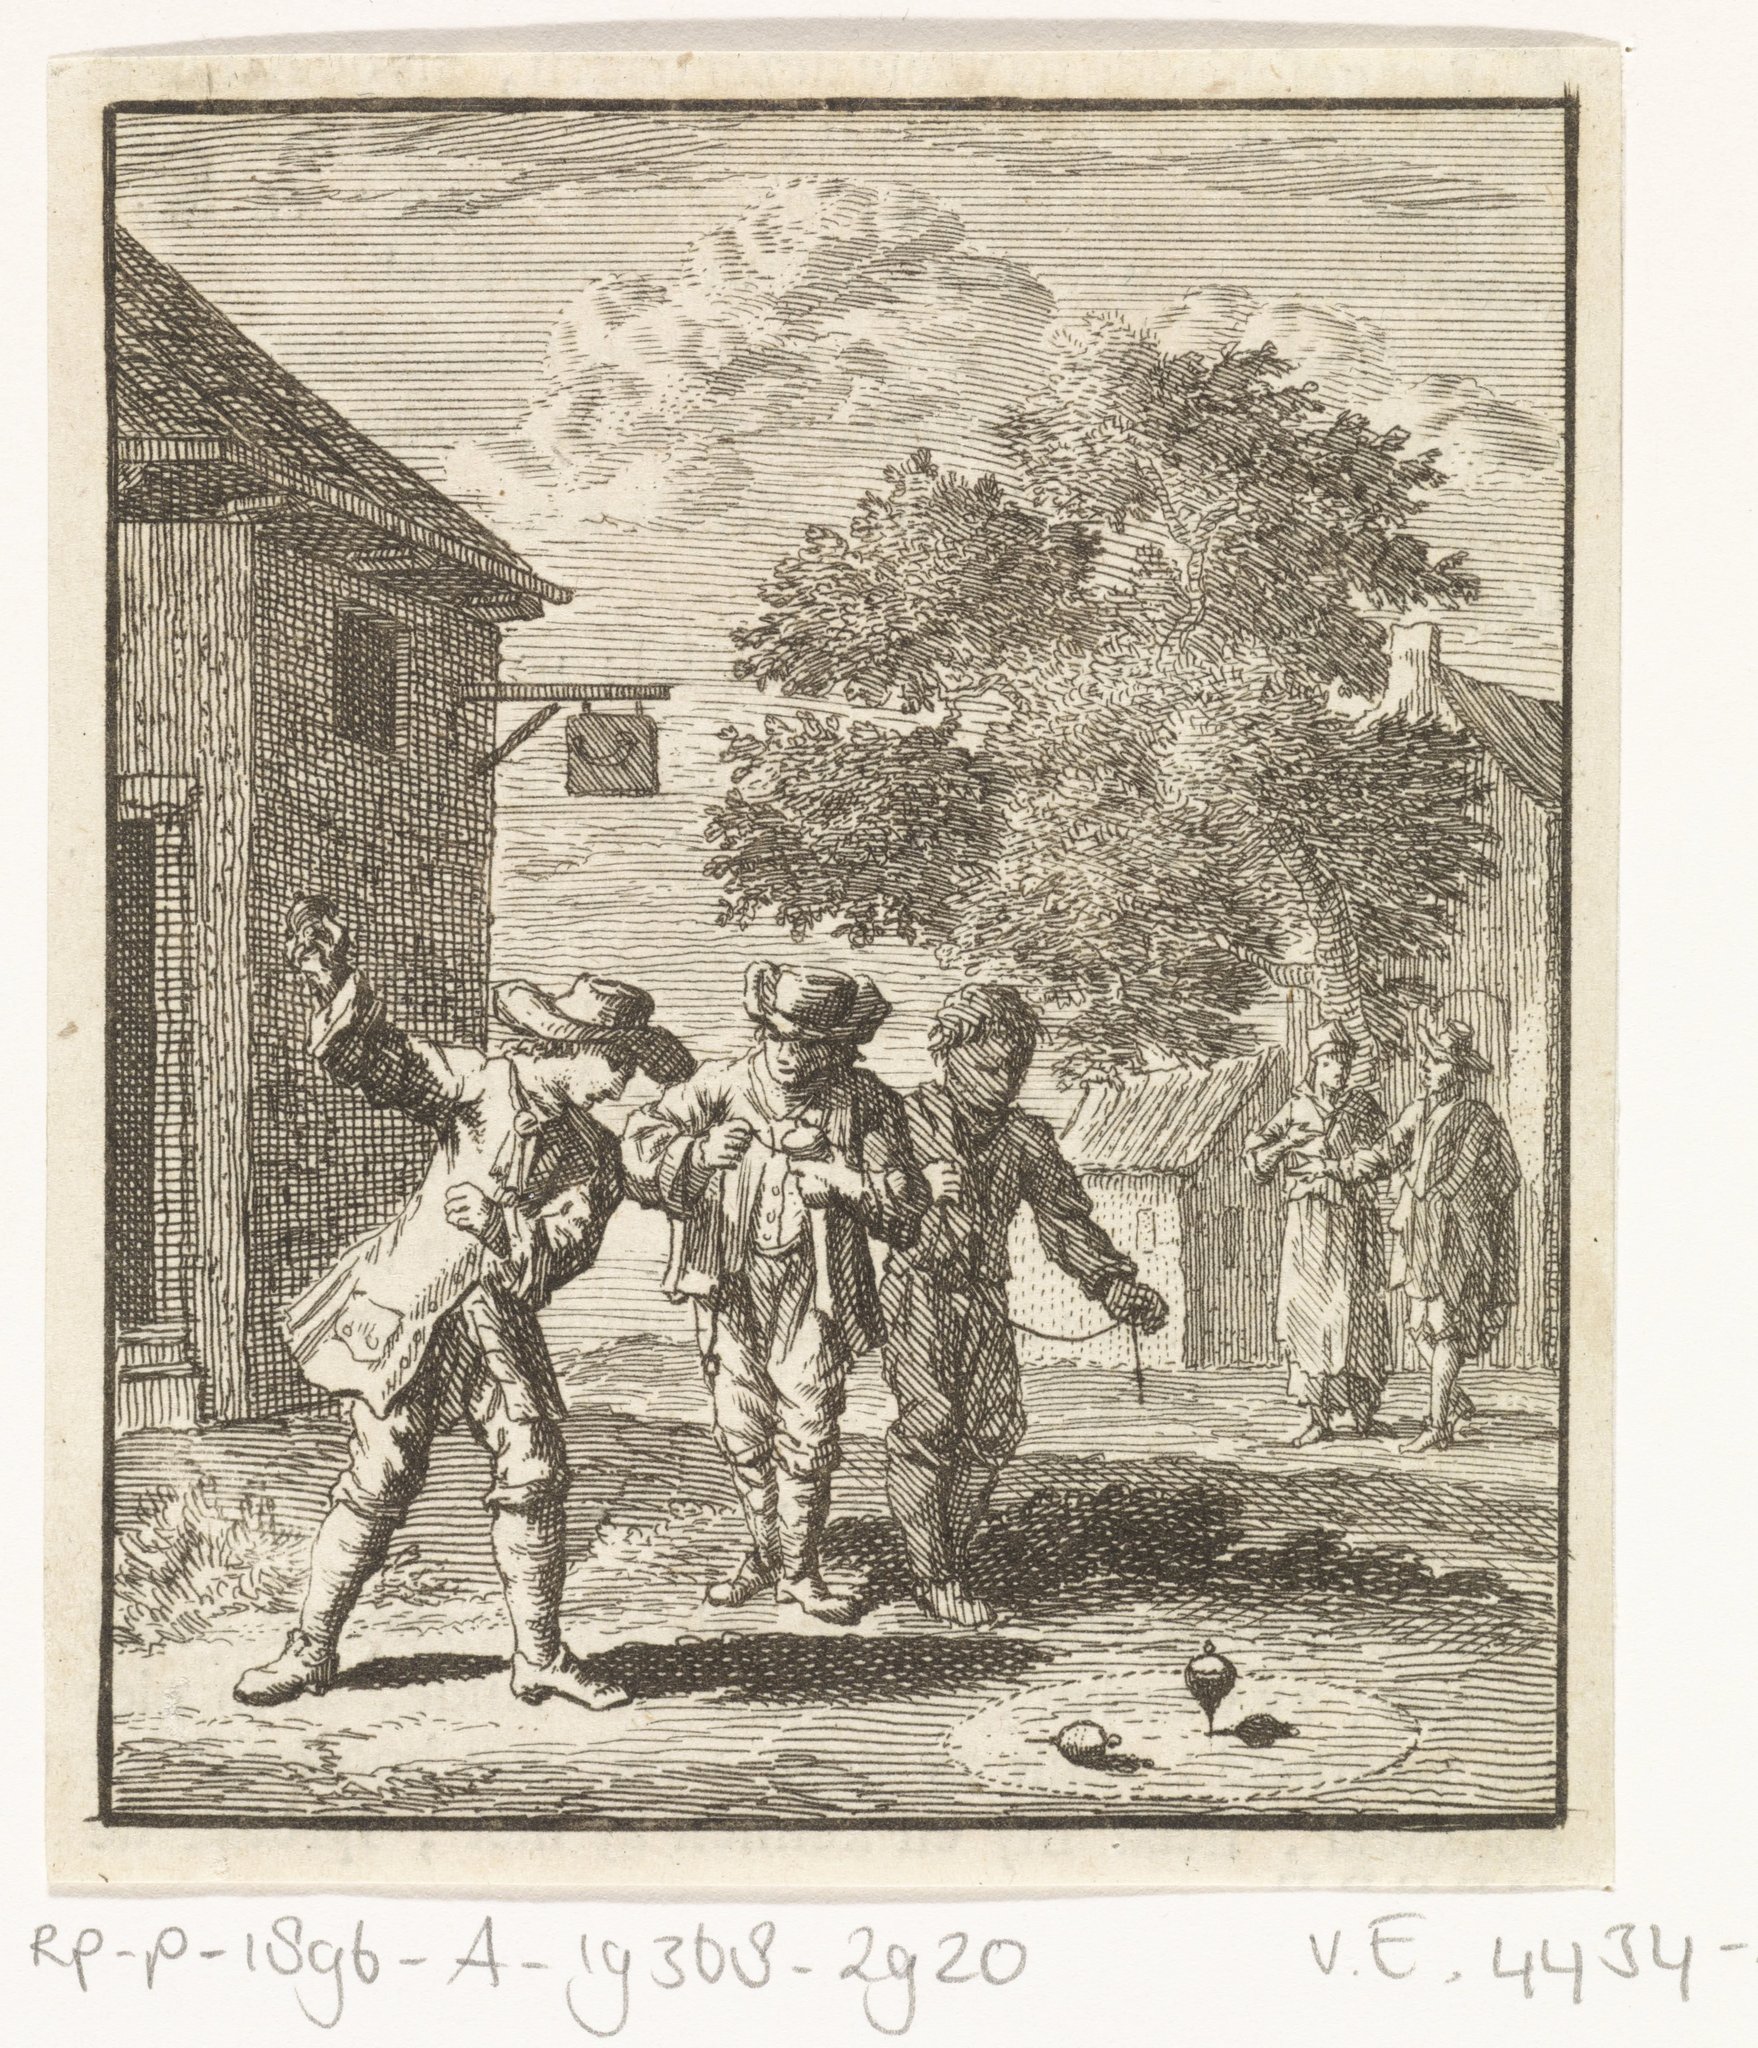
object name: print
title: De Werptol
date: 1712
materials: paper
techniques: etching, letterpress printing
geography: amsterdam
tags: (playing with) top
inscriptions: collector's mark: Lugt 2228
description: Illustratie uit: Luyken, Jan. Des menschen begin, midden en einde. Amsterdam: Wed. Pieter Arentsz II en Cornelis van der Sys, 1712, p. 79.